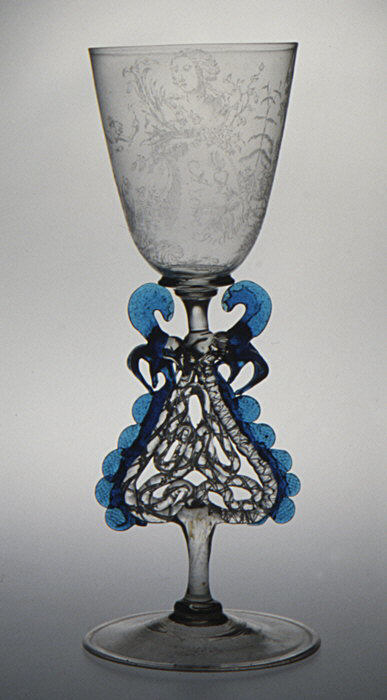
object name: standing cup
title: Standing cup (Flügelglas)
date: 1760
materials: glass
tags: faces